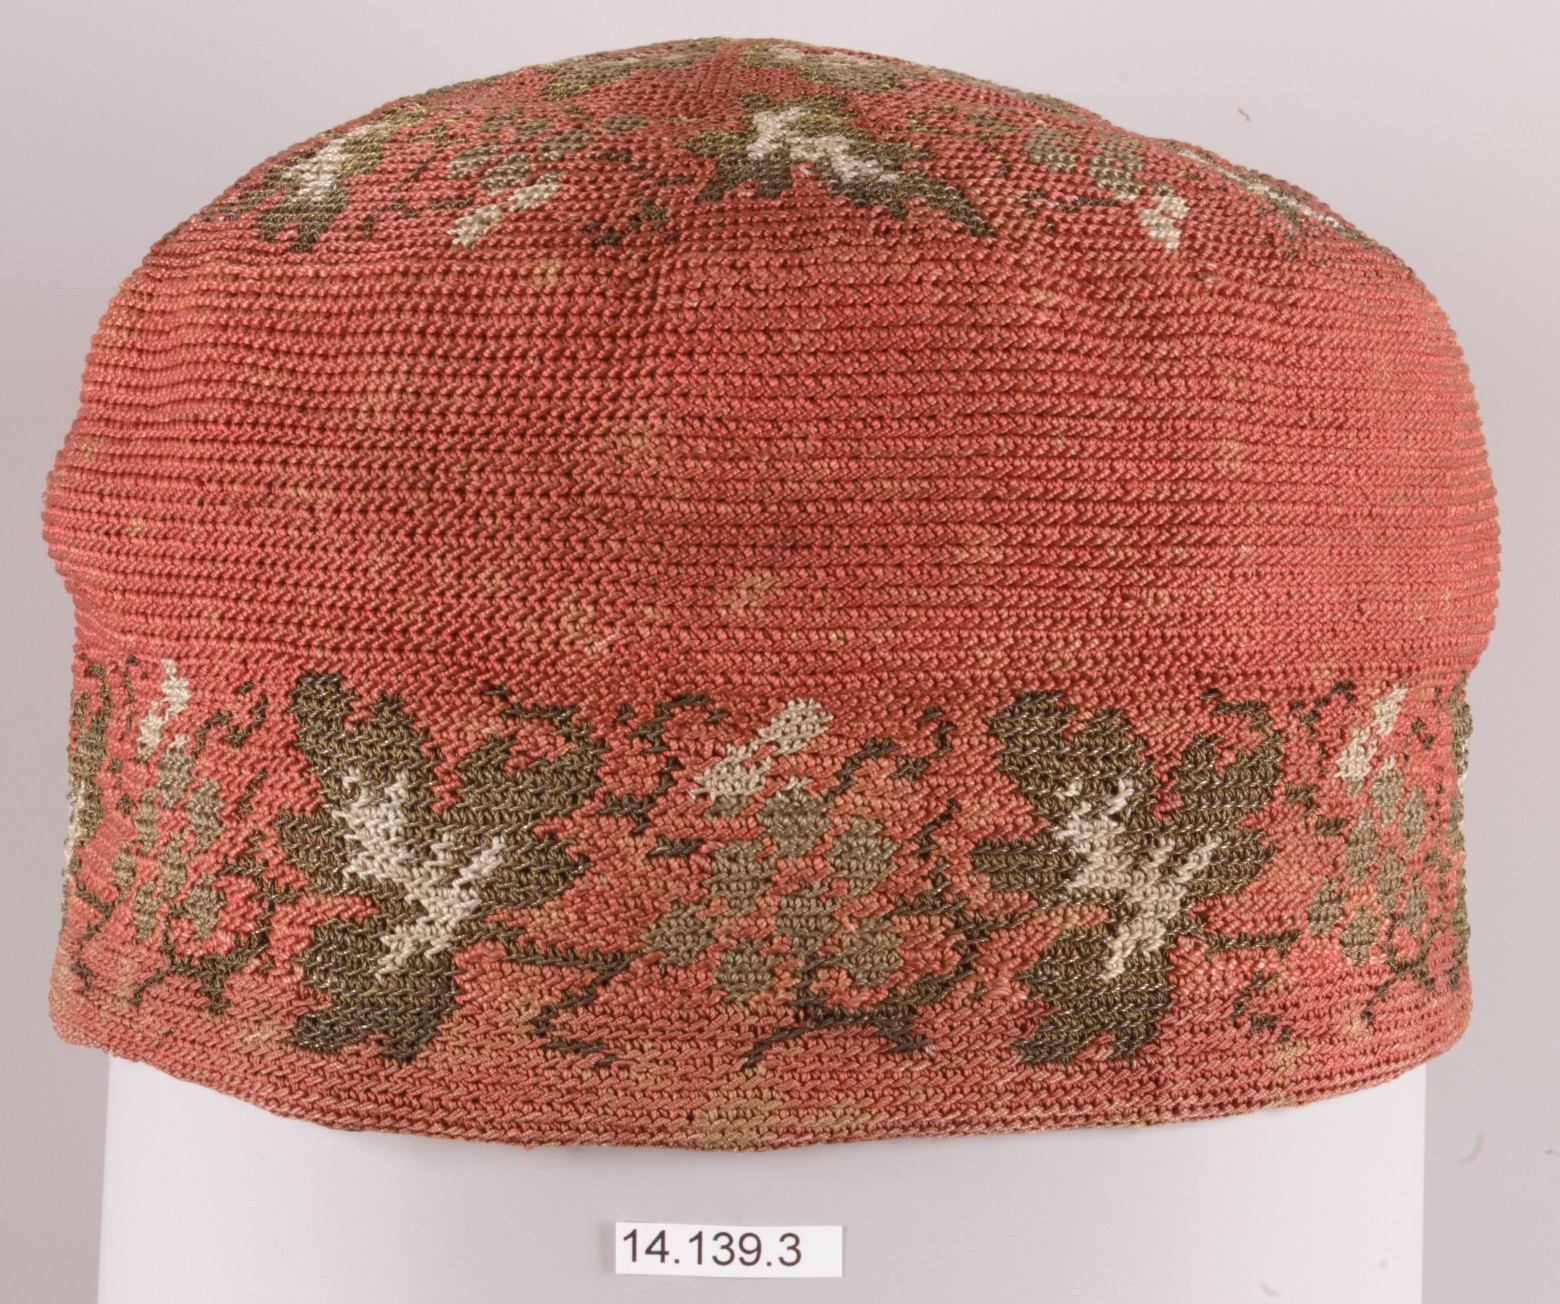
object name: cap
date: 1701-1800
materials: silk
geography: turkey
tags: hats